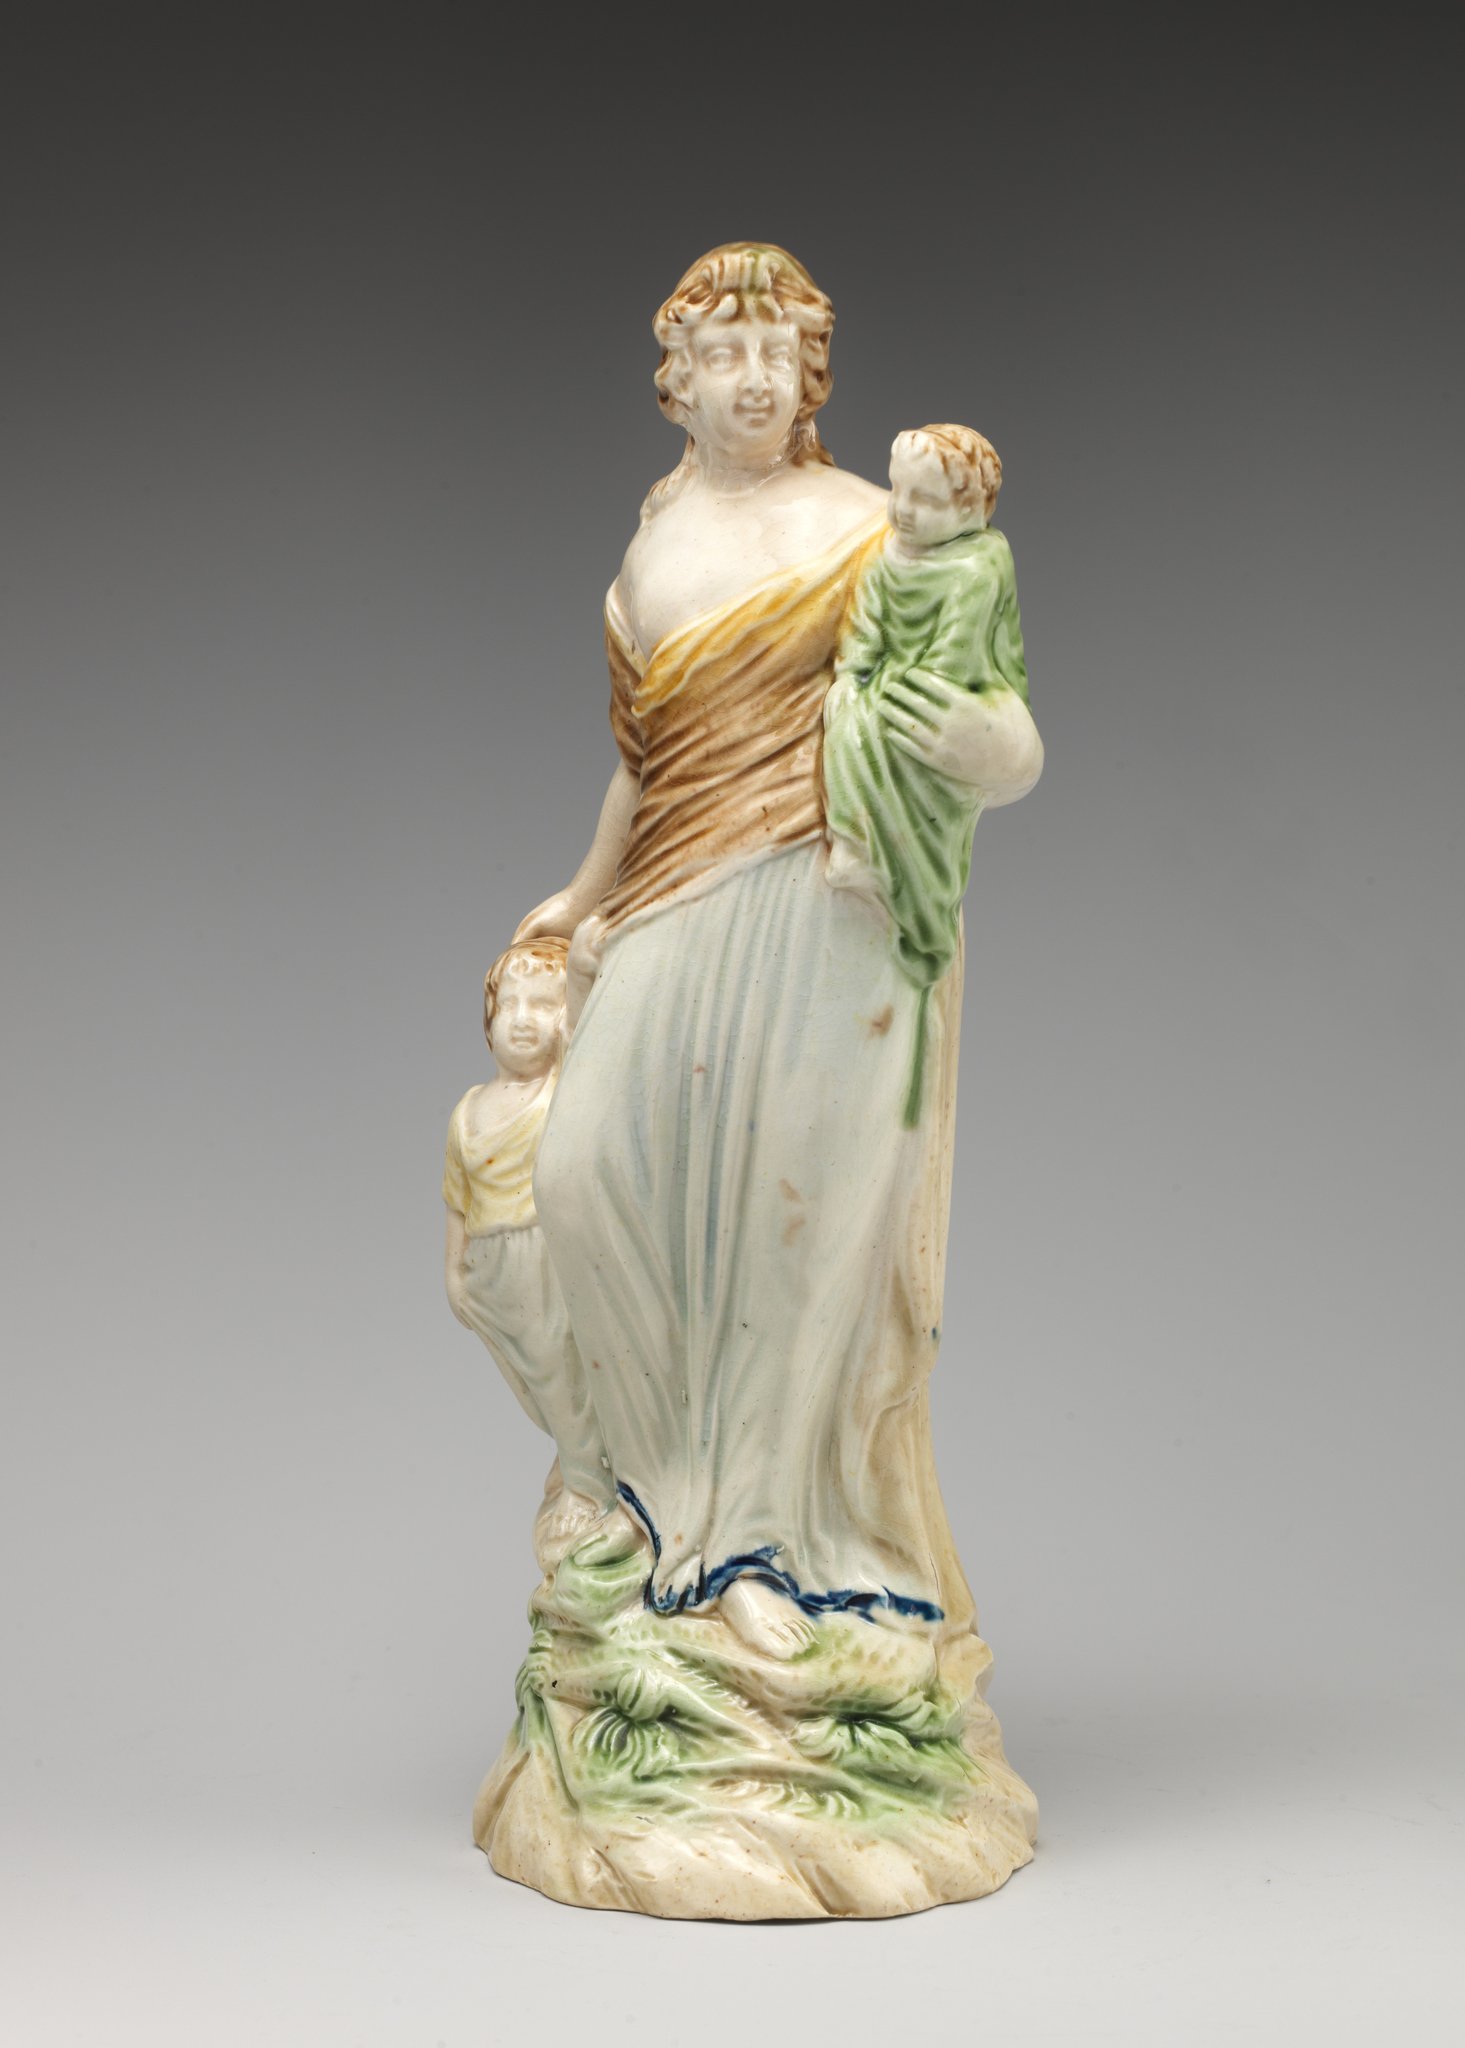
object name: figure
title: Charity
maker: ralph wood the younger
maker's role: maker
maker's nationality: british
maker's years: 1748-1795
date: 1770-1780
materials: earthenware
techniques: glazing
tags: boys,girls,women